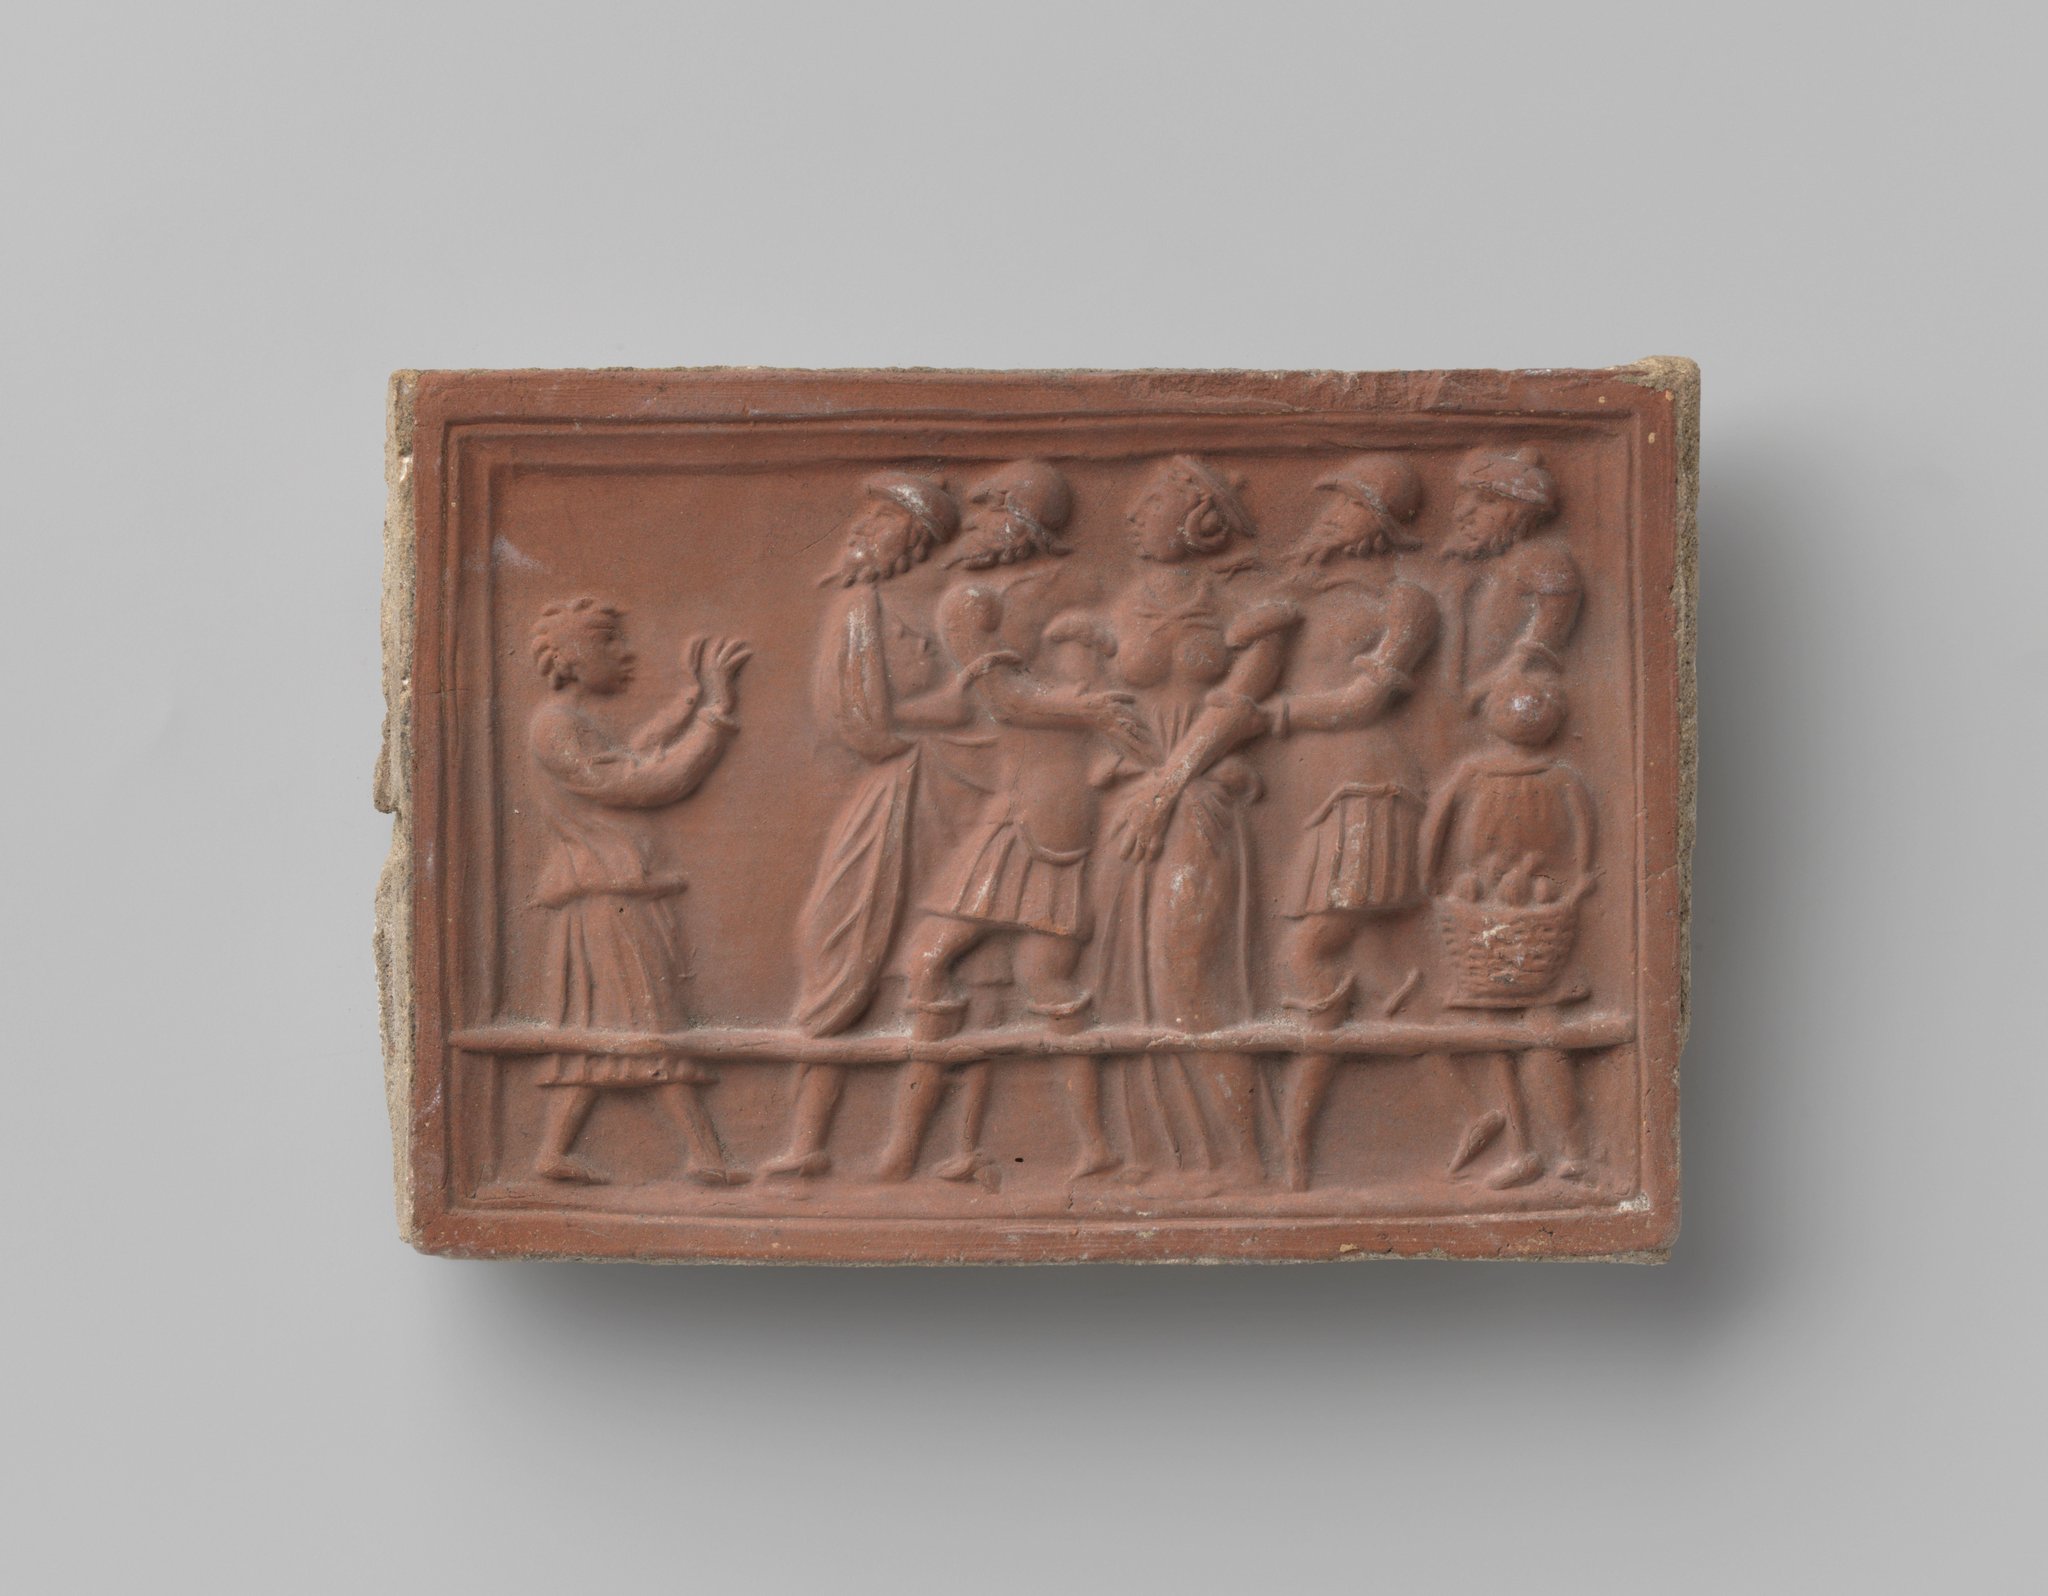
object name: hearthstone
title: Haardsteen met voorstelling van de ter dood veroordeelde Suzanna, die door Daniël tegemoet wordt getreden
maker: Anonymous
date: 1875-1900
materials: earthenware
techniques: printing, firing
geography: netherlands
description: Haardsteen met voorstelling van de ter dood veroordeelde Suzanna, die door Daniël tegemoet wordt getreden. Rechts draagt een jongen een mand met stenen aan.